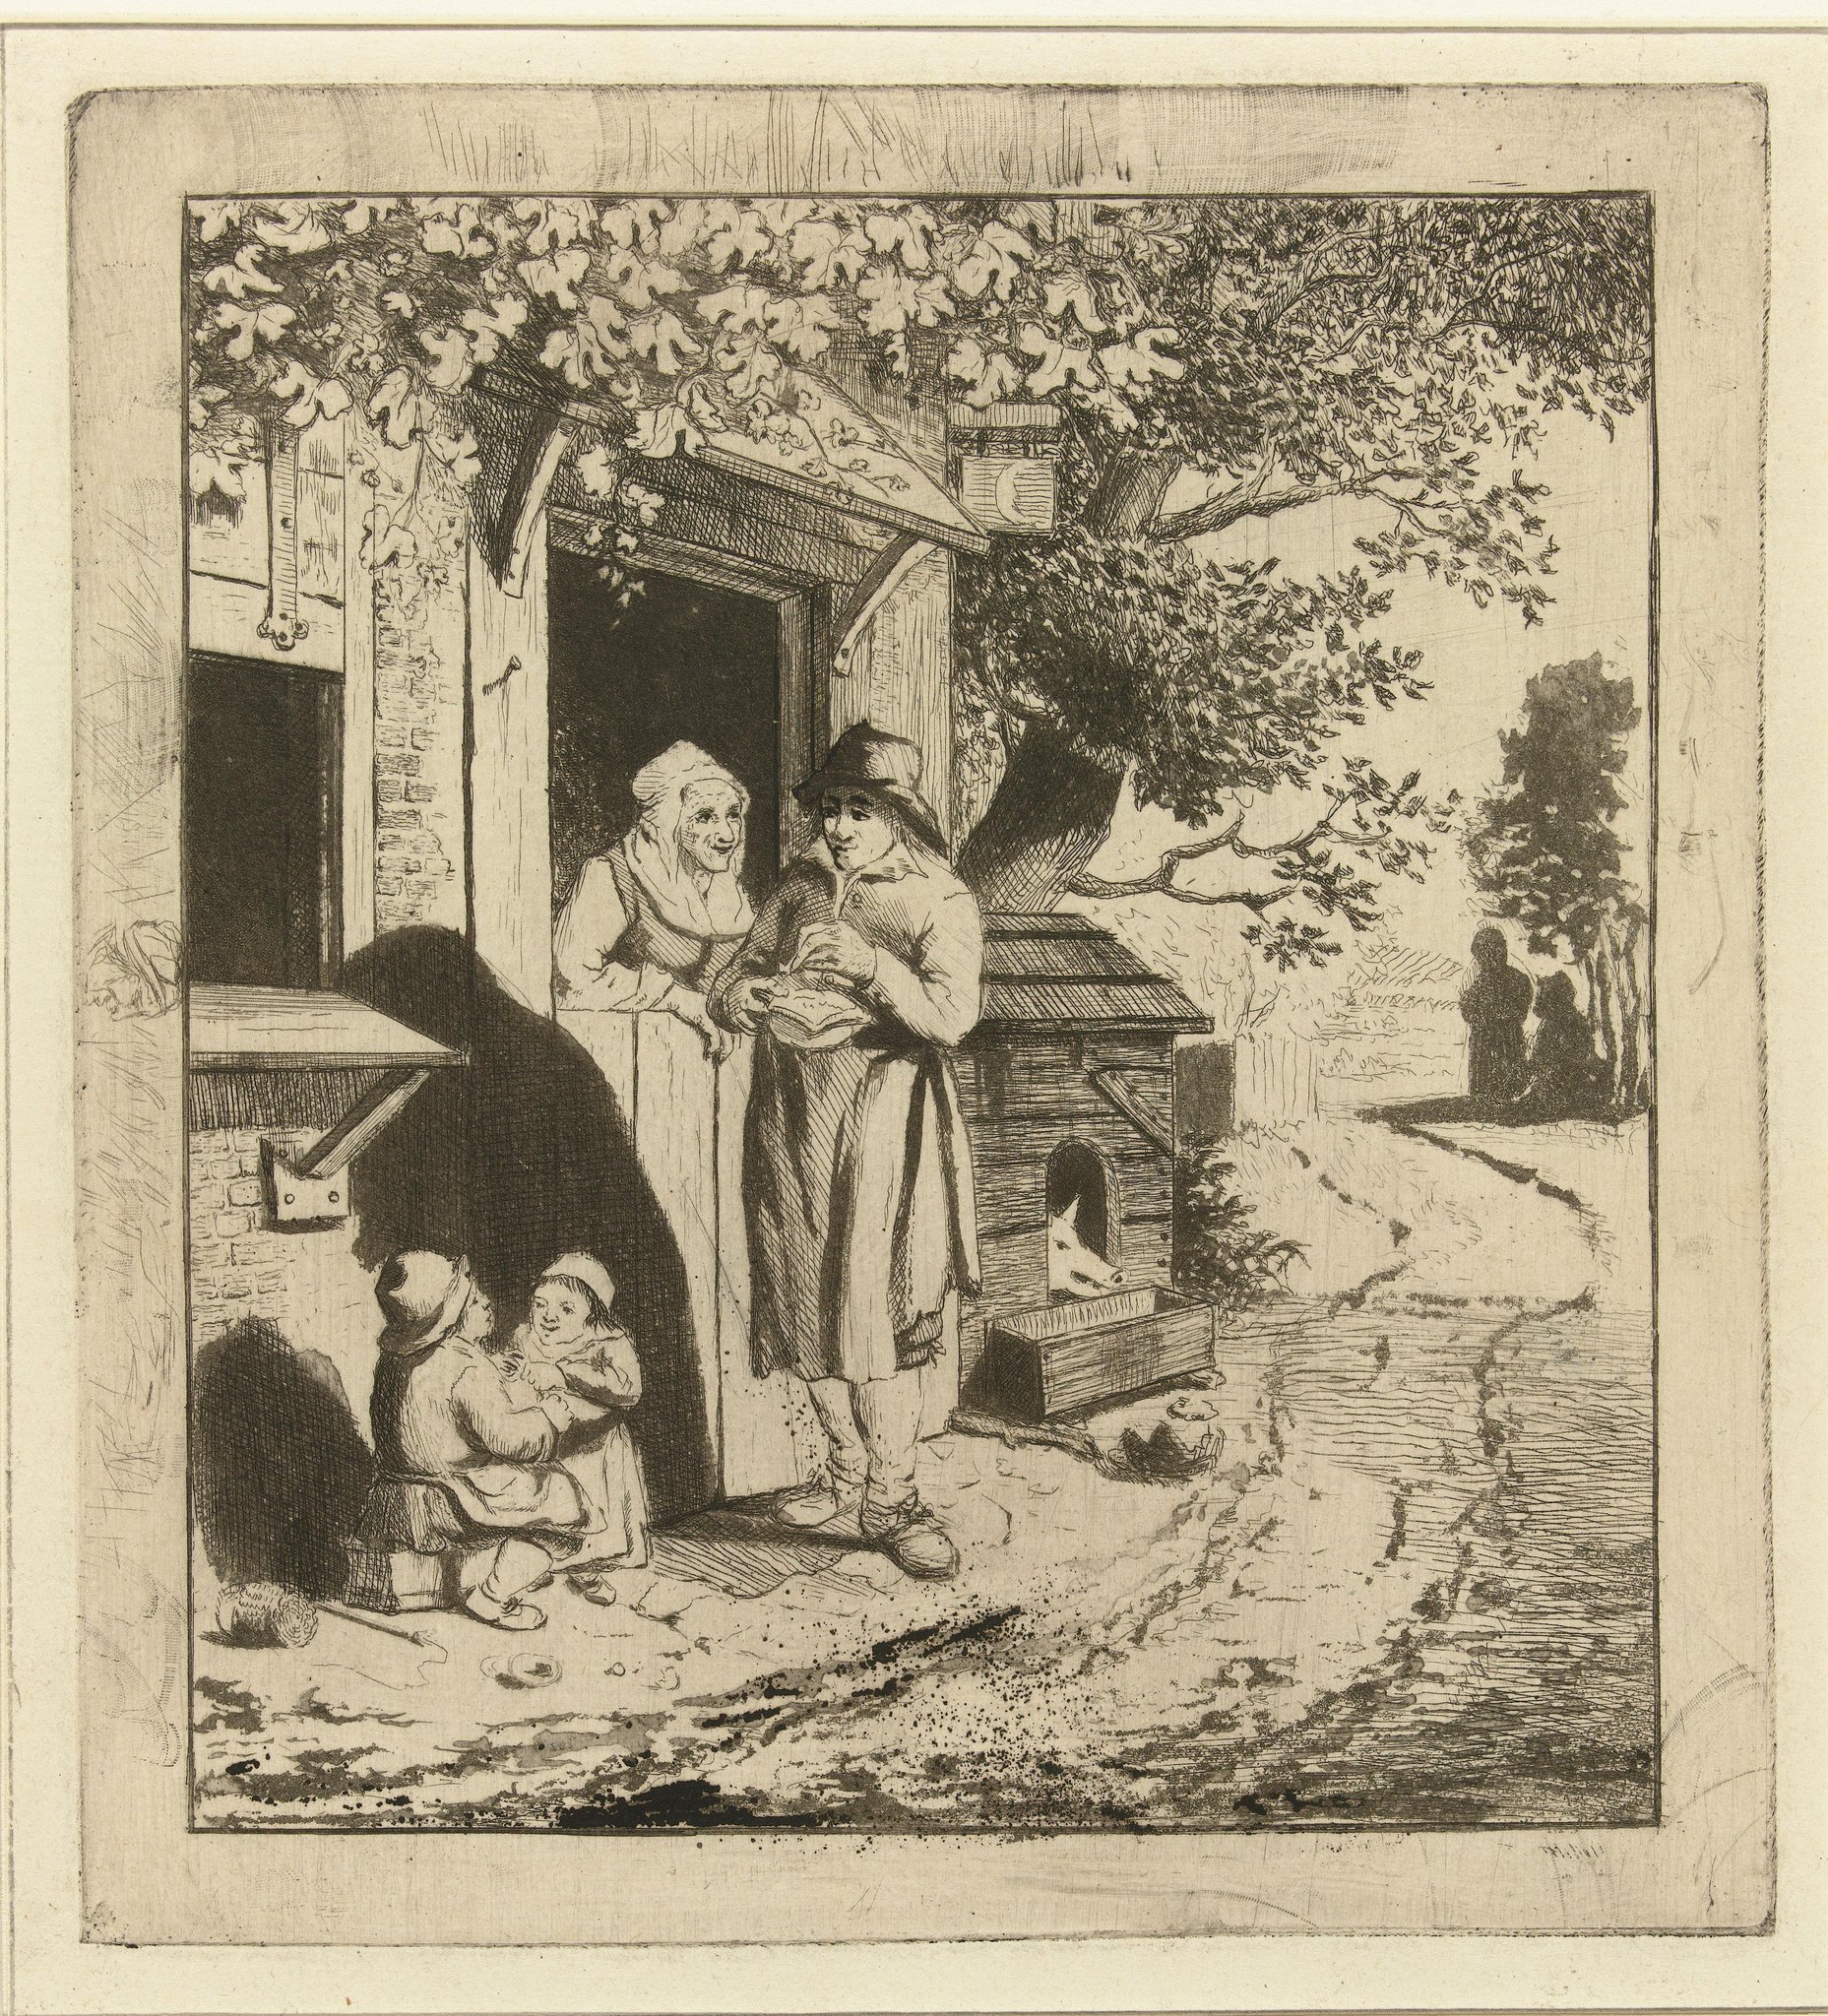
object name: print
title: Man aan de deur van een herberg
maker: marie lambertine coclers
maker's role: conservator, draughtsman, print maker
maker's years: 1761-1815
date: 1776-1815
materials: paper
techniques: aquatint, etching, roulette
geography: amsterdam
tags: hotel, hostelry, inn, divided door, upper part opened - aa - feigned door, sham-door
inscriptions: collector's mark: Lugt 2228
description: Voor de deur van een herberg staat een man te kletsen met een oude vrouw die op de onderdeur van het huis leunt. Voor de deur spelen twee kinderen op de grond. Rechts is een varkensstal. De man stopt zijn pijp terwijl hij met de oude vrouw praat. Op de achtergrond nog twee figuren rechts onder een boom. Links in de marge een remarque.